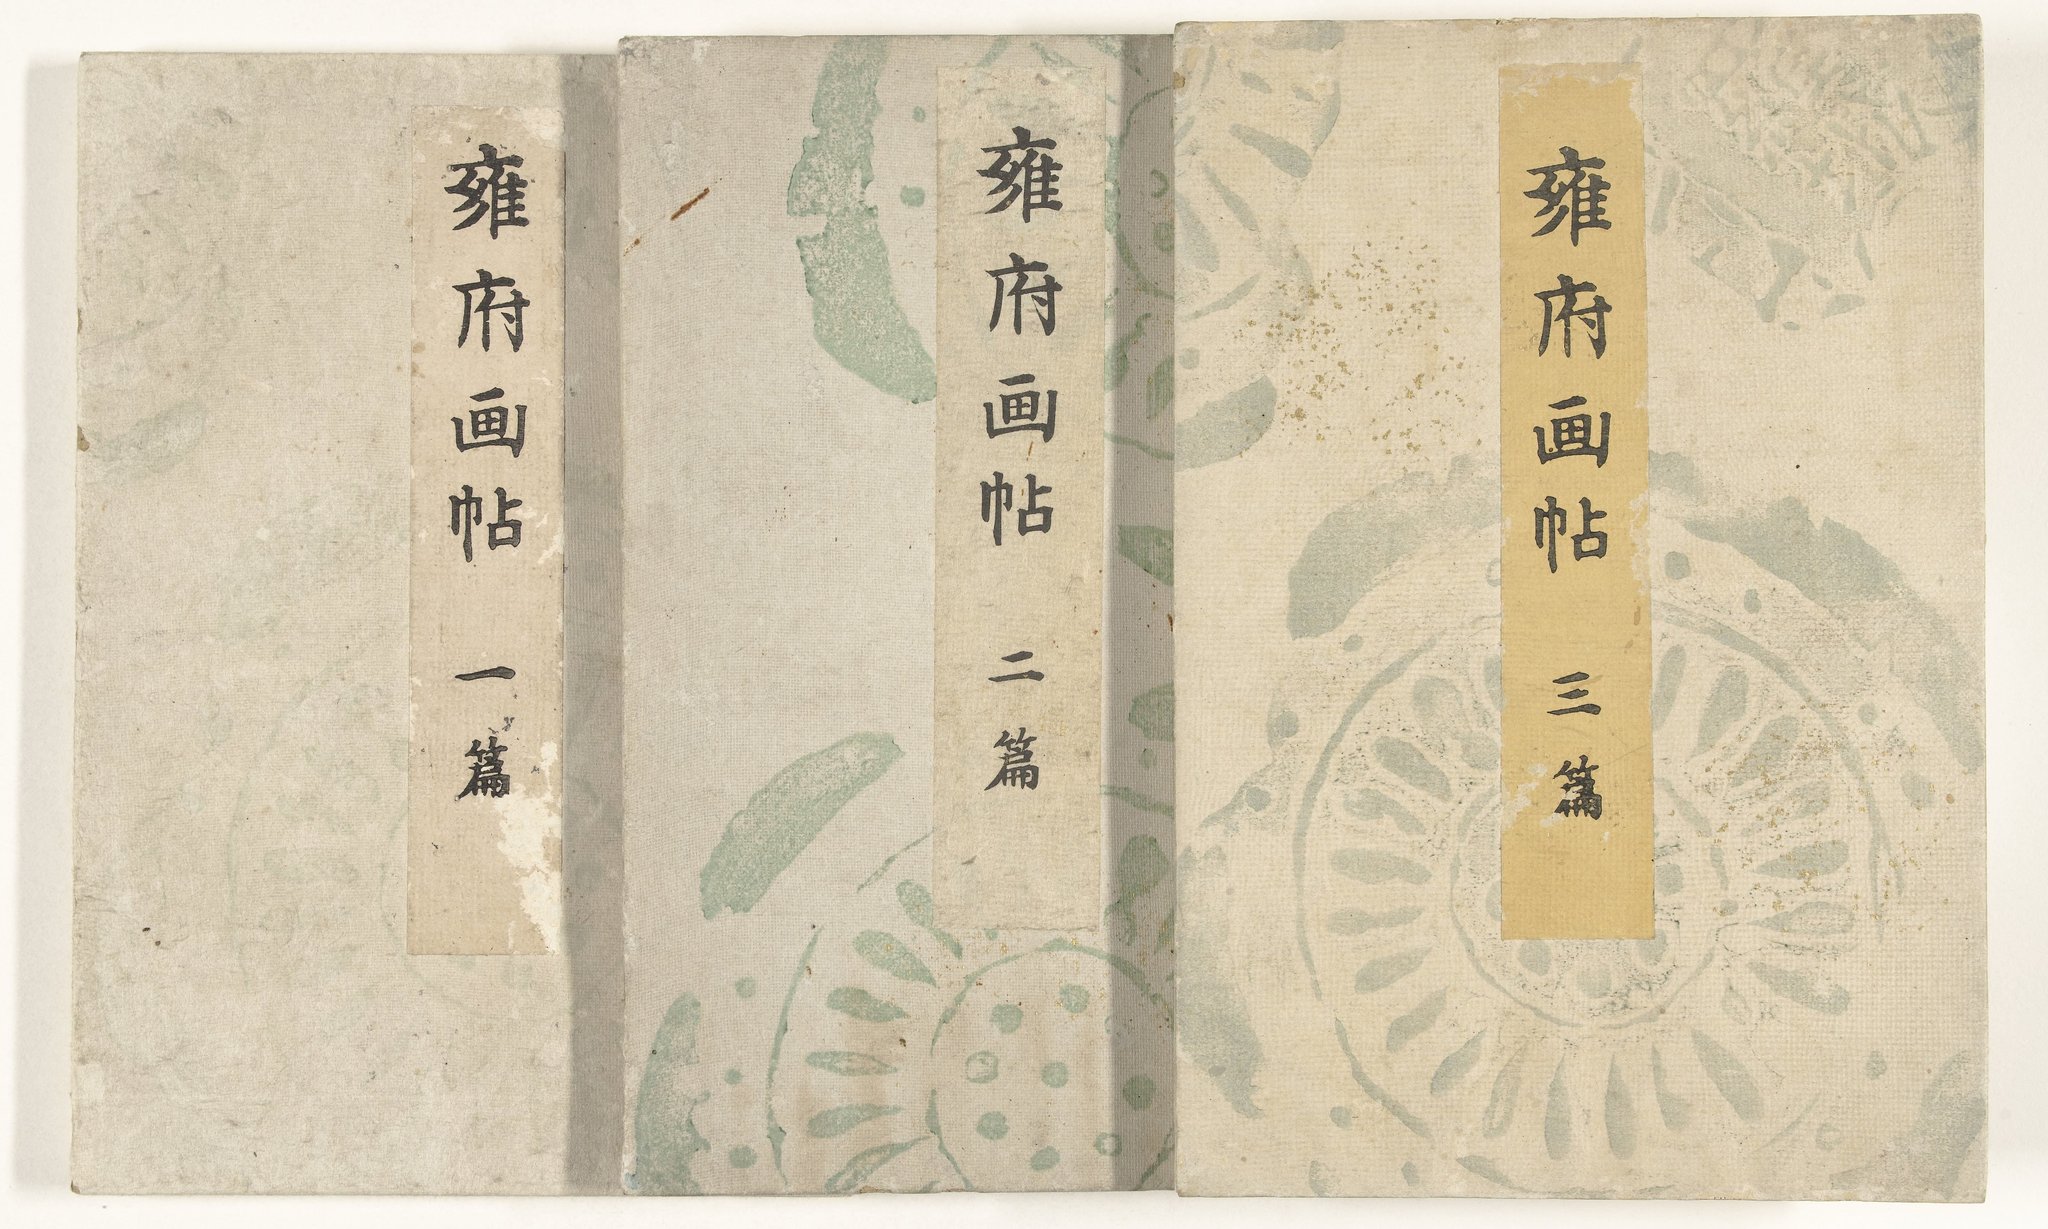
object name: book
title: Kyoto prentenboek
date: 1895-1898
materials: paper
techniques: woodcut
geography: japan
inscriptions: collector's mark: Lugt 2228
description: Drie delen (compleet) met landschappen in de rond Kyoto. Bewaard in een gele cassette.